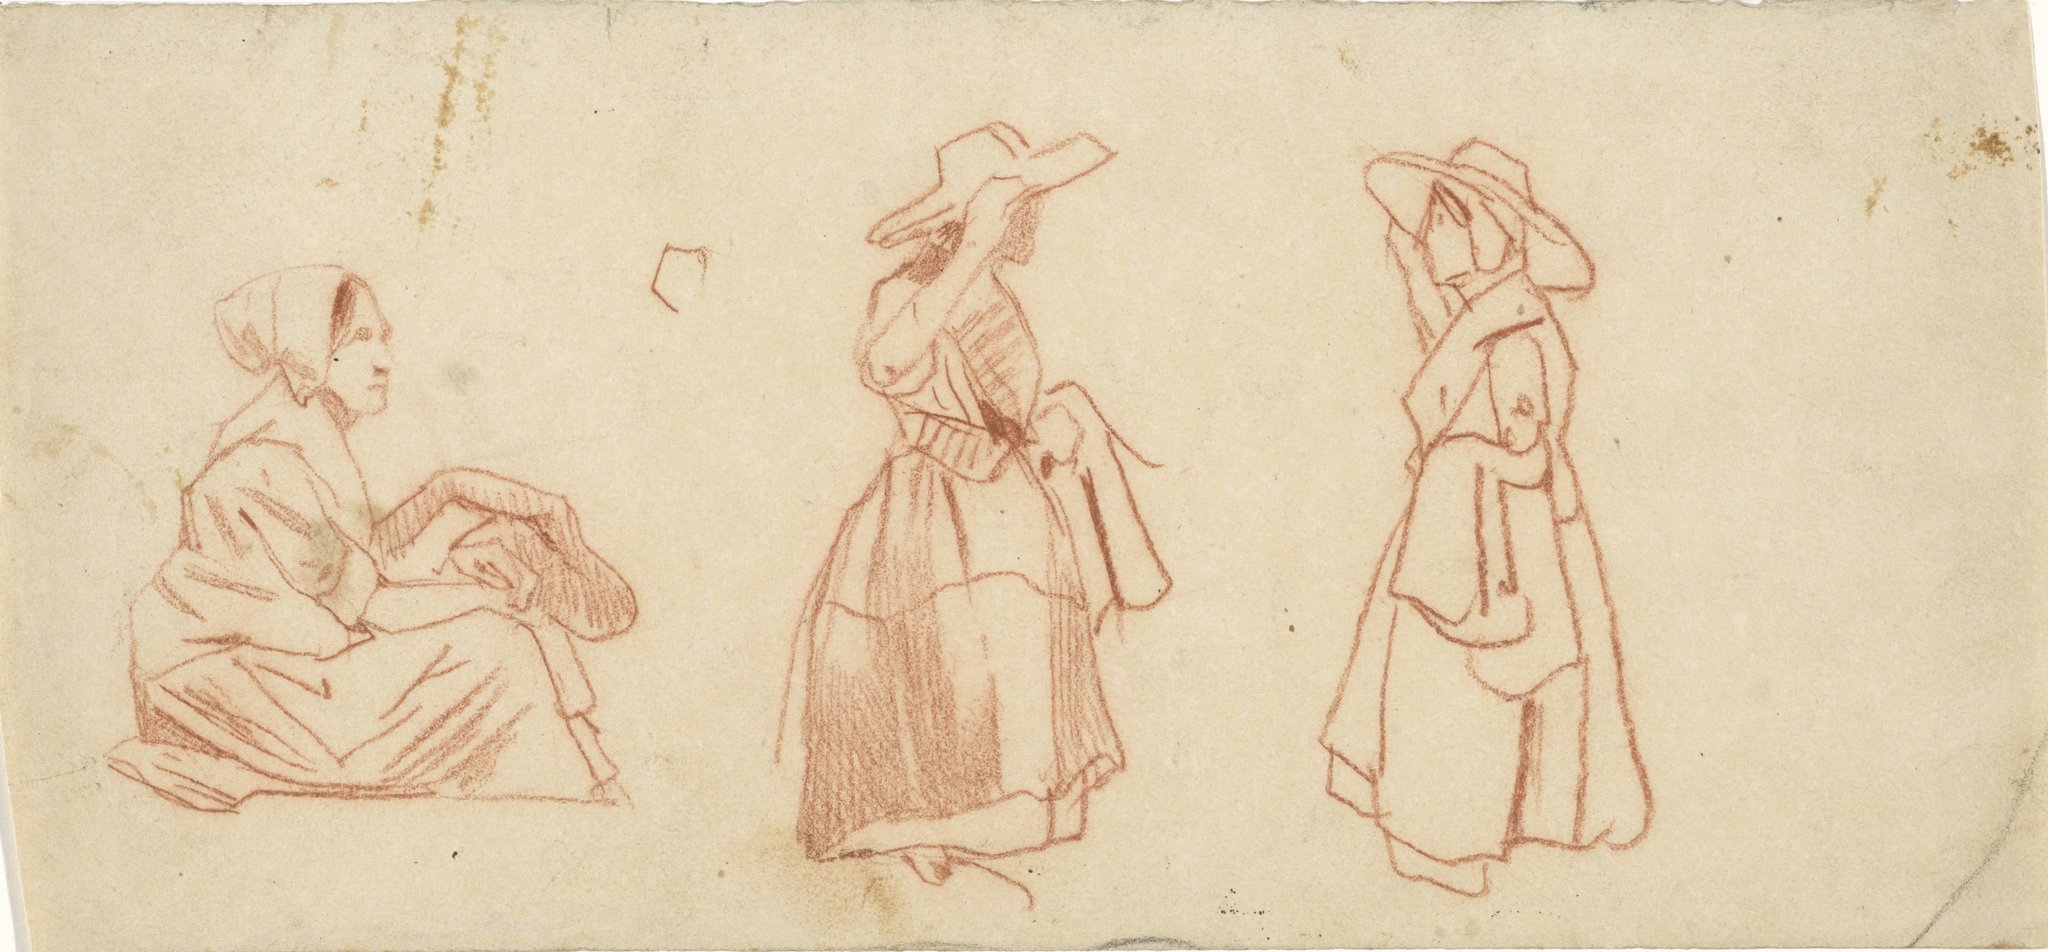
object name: drawing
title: Drie studies van vrouwen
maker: johannes bosboom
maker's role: draughtsman, painter, print maker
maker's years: 1817-1891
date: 1827-1891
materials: chalk, paper